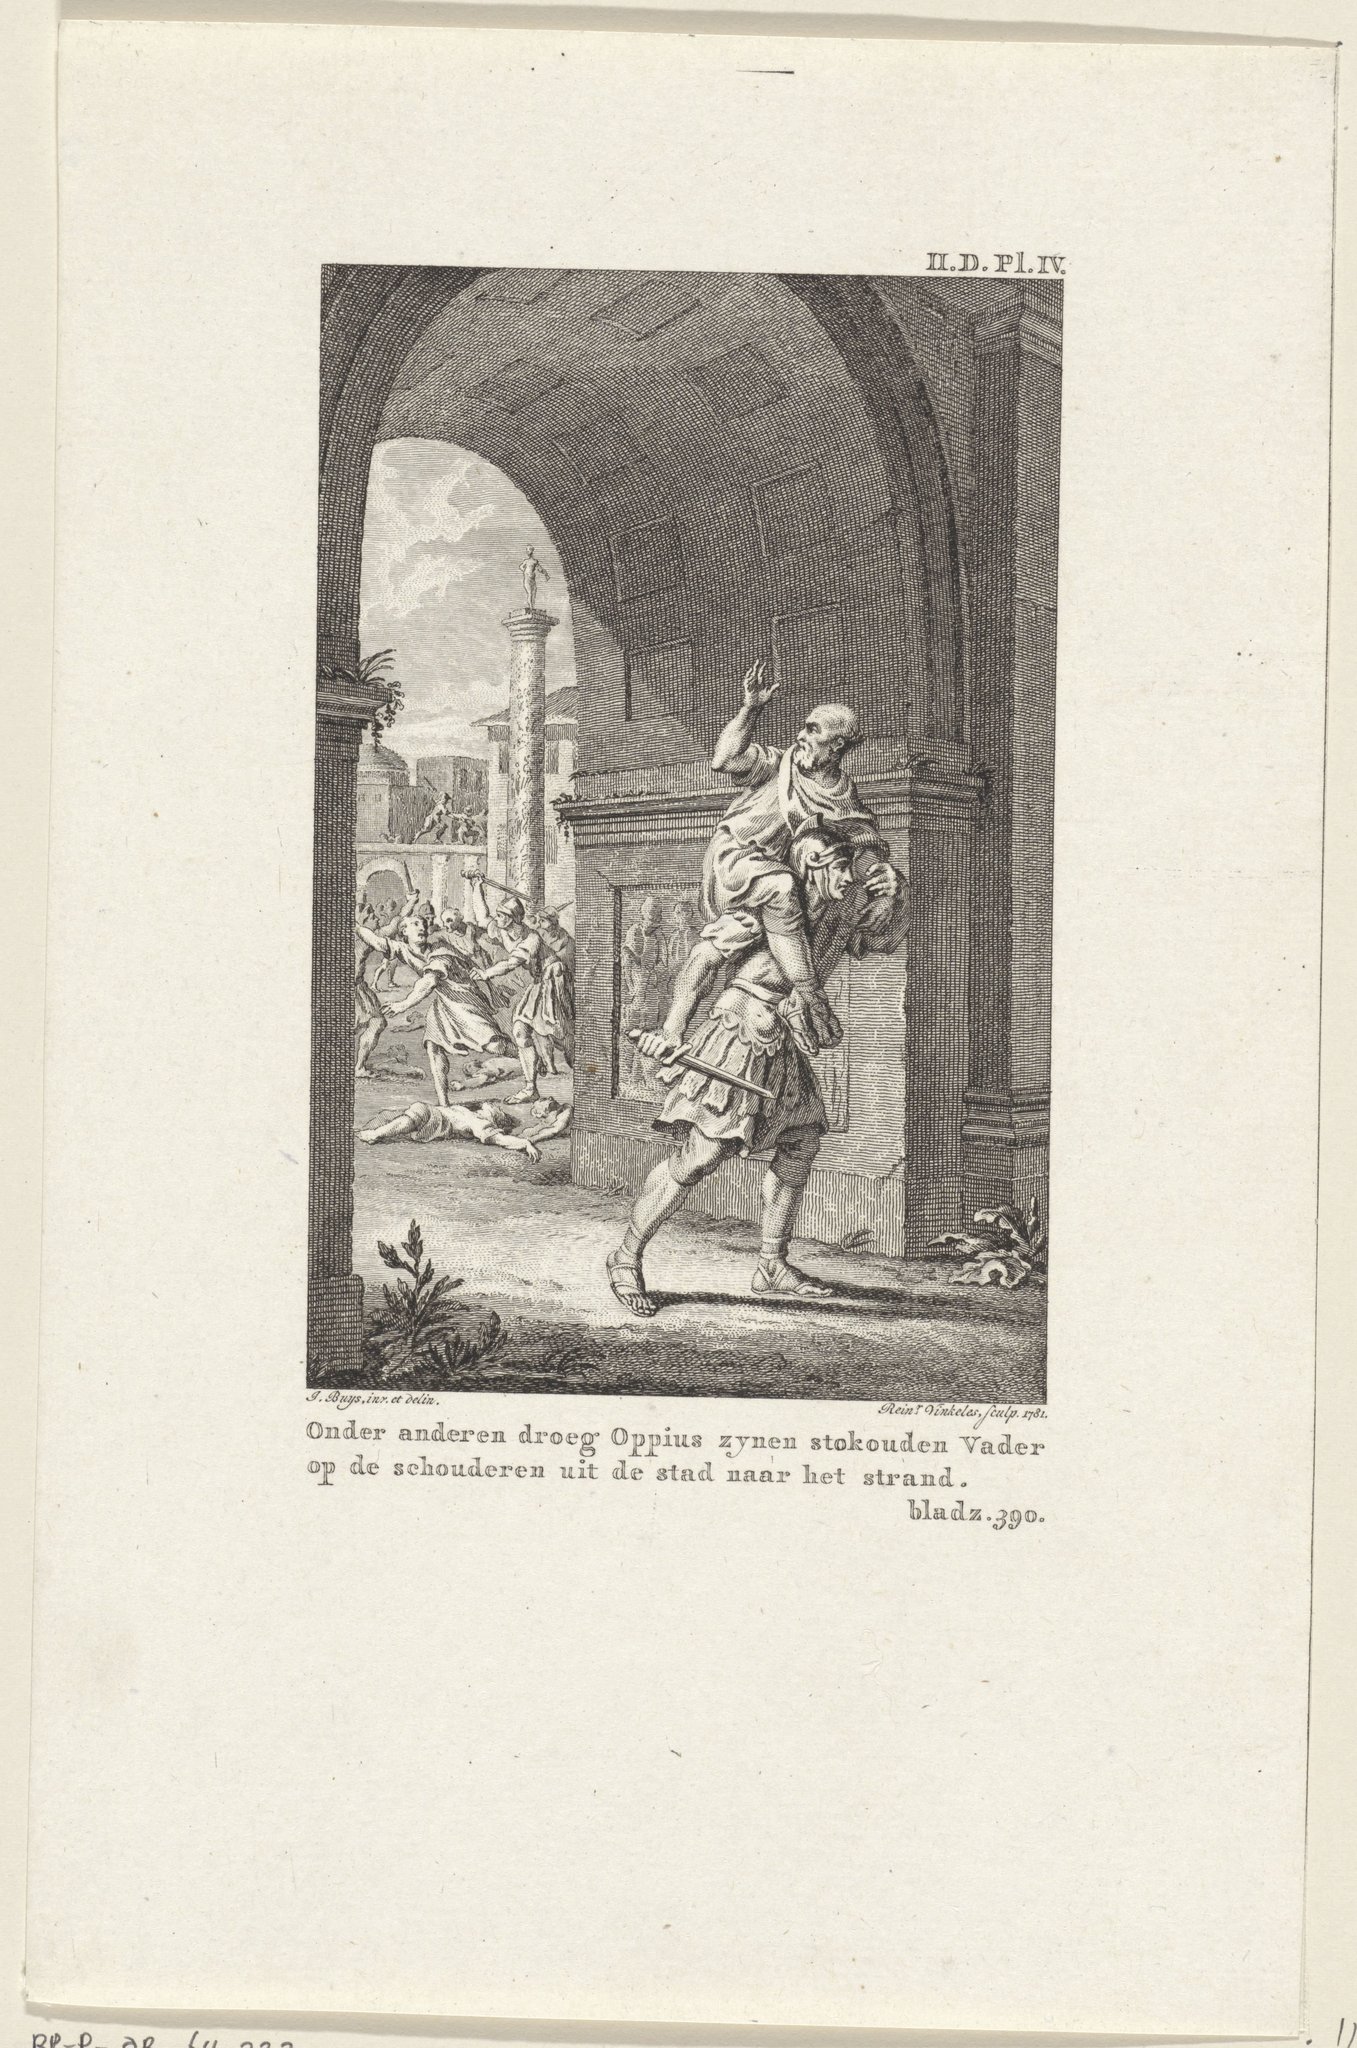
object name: book illustration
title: Oppius wordt door zijn zoon uit Rome gedragen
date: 1781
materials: paper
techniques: engraving, etching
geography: amsterdam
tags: carrying a person on one's back, rome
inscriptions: collector's mark: Lugt 240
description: Prent gebruikt als boekillustratie in: Martinet, Joannes Florentius. Historie der waereld. Amsterdam: Johannes Allart, 1780-1788. 25 delen. deel II, pl. IV.